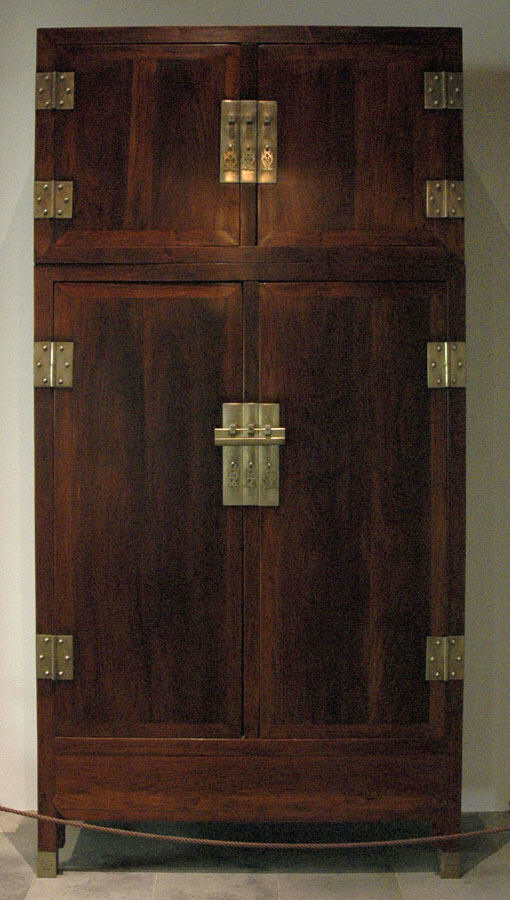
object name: wardrobe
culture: chinese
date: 1501-1600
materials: metal, wood